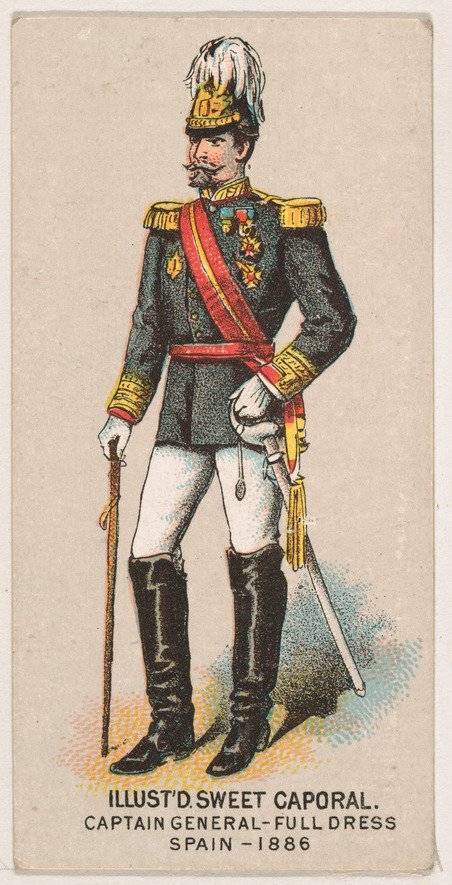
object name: print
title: Full Dress, Captain General, Spain, 1886, from the Military Series (N224) issued by Kinney Tobacco Company to promote Sweet Caporal Cigarettes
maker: kinney brothers tobacco company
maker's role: publisher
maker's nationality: american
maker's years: 1869-2011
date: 1888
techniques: color lithograph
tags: military,men,generals